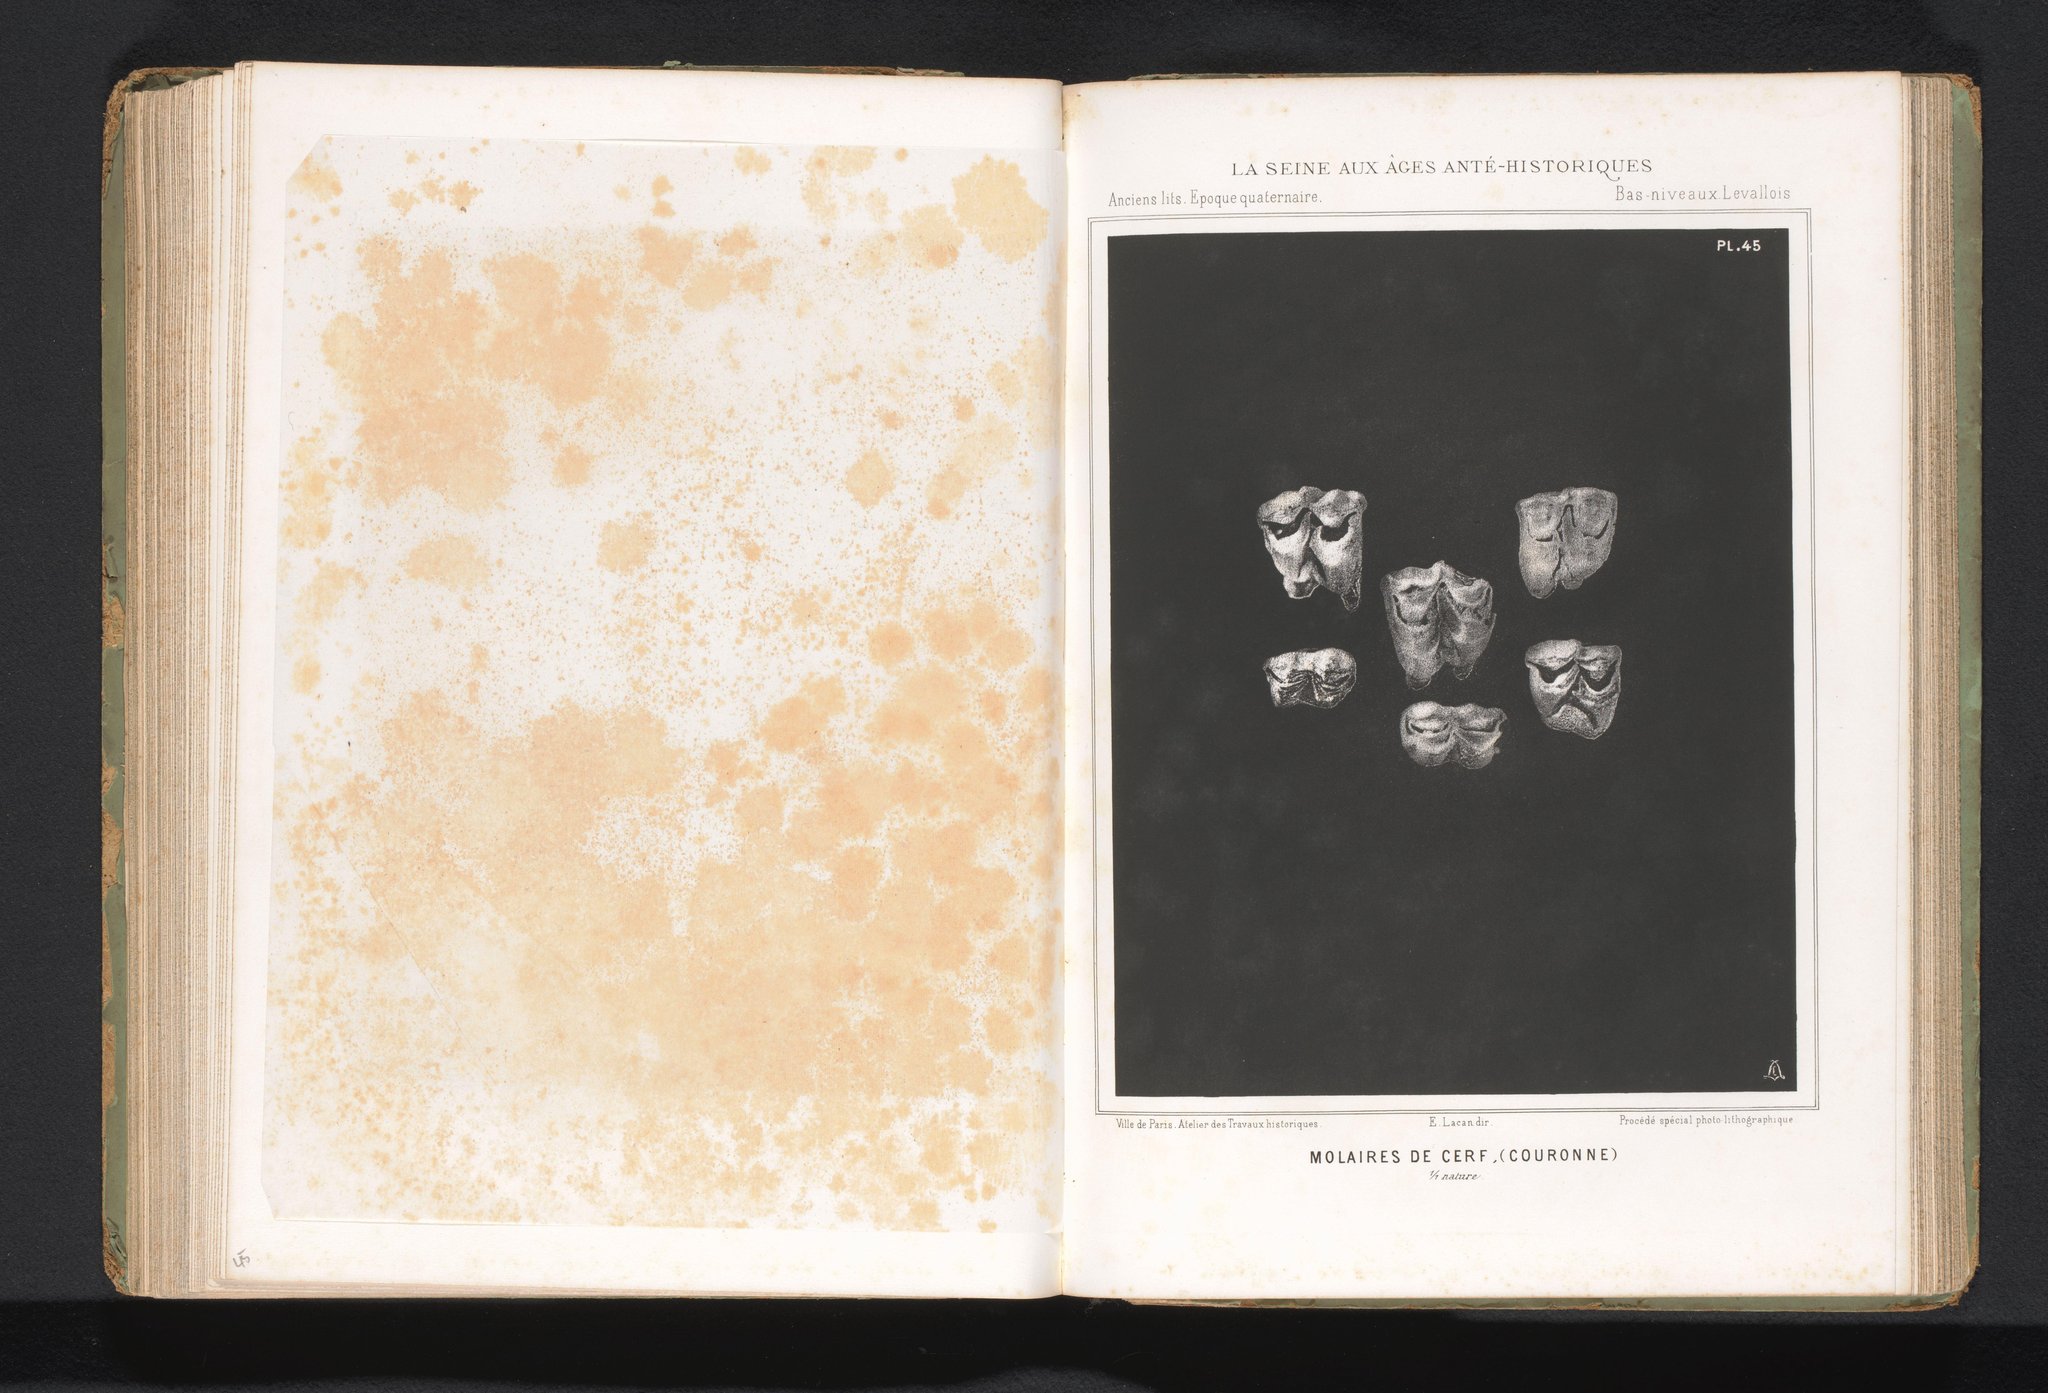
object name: photomechanical print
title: Molaires de cerf, couronne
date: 1864-1869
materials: paper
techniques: photolithography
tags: animals (+ skeleton of an animal), palaeontology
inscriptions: inscription: ‘1/1 nature’, inscription: ‘Procédé spécial photo-lithographique’, inscription: ‘PL. 45’, monogram: ‘EL’